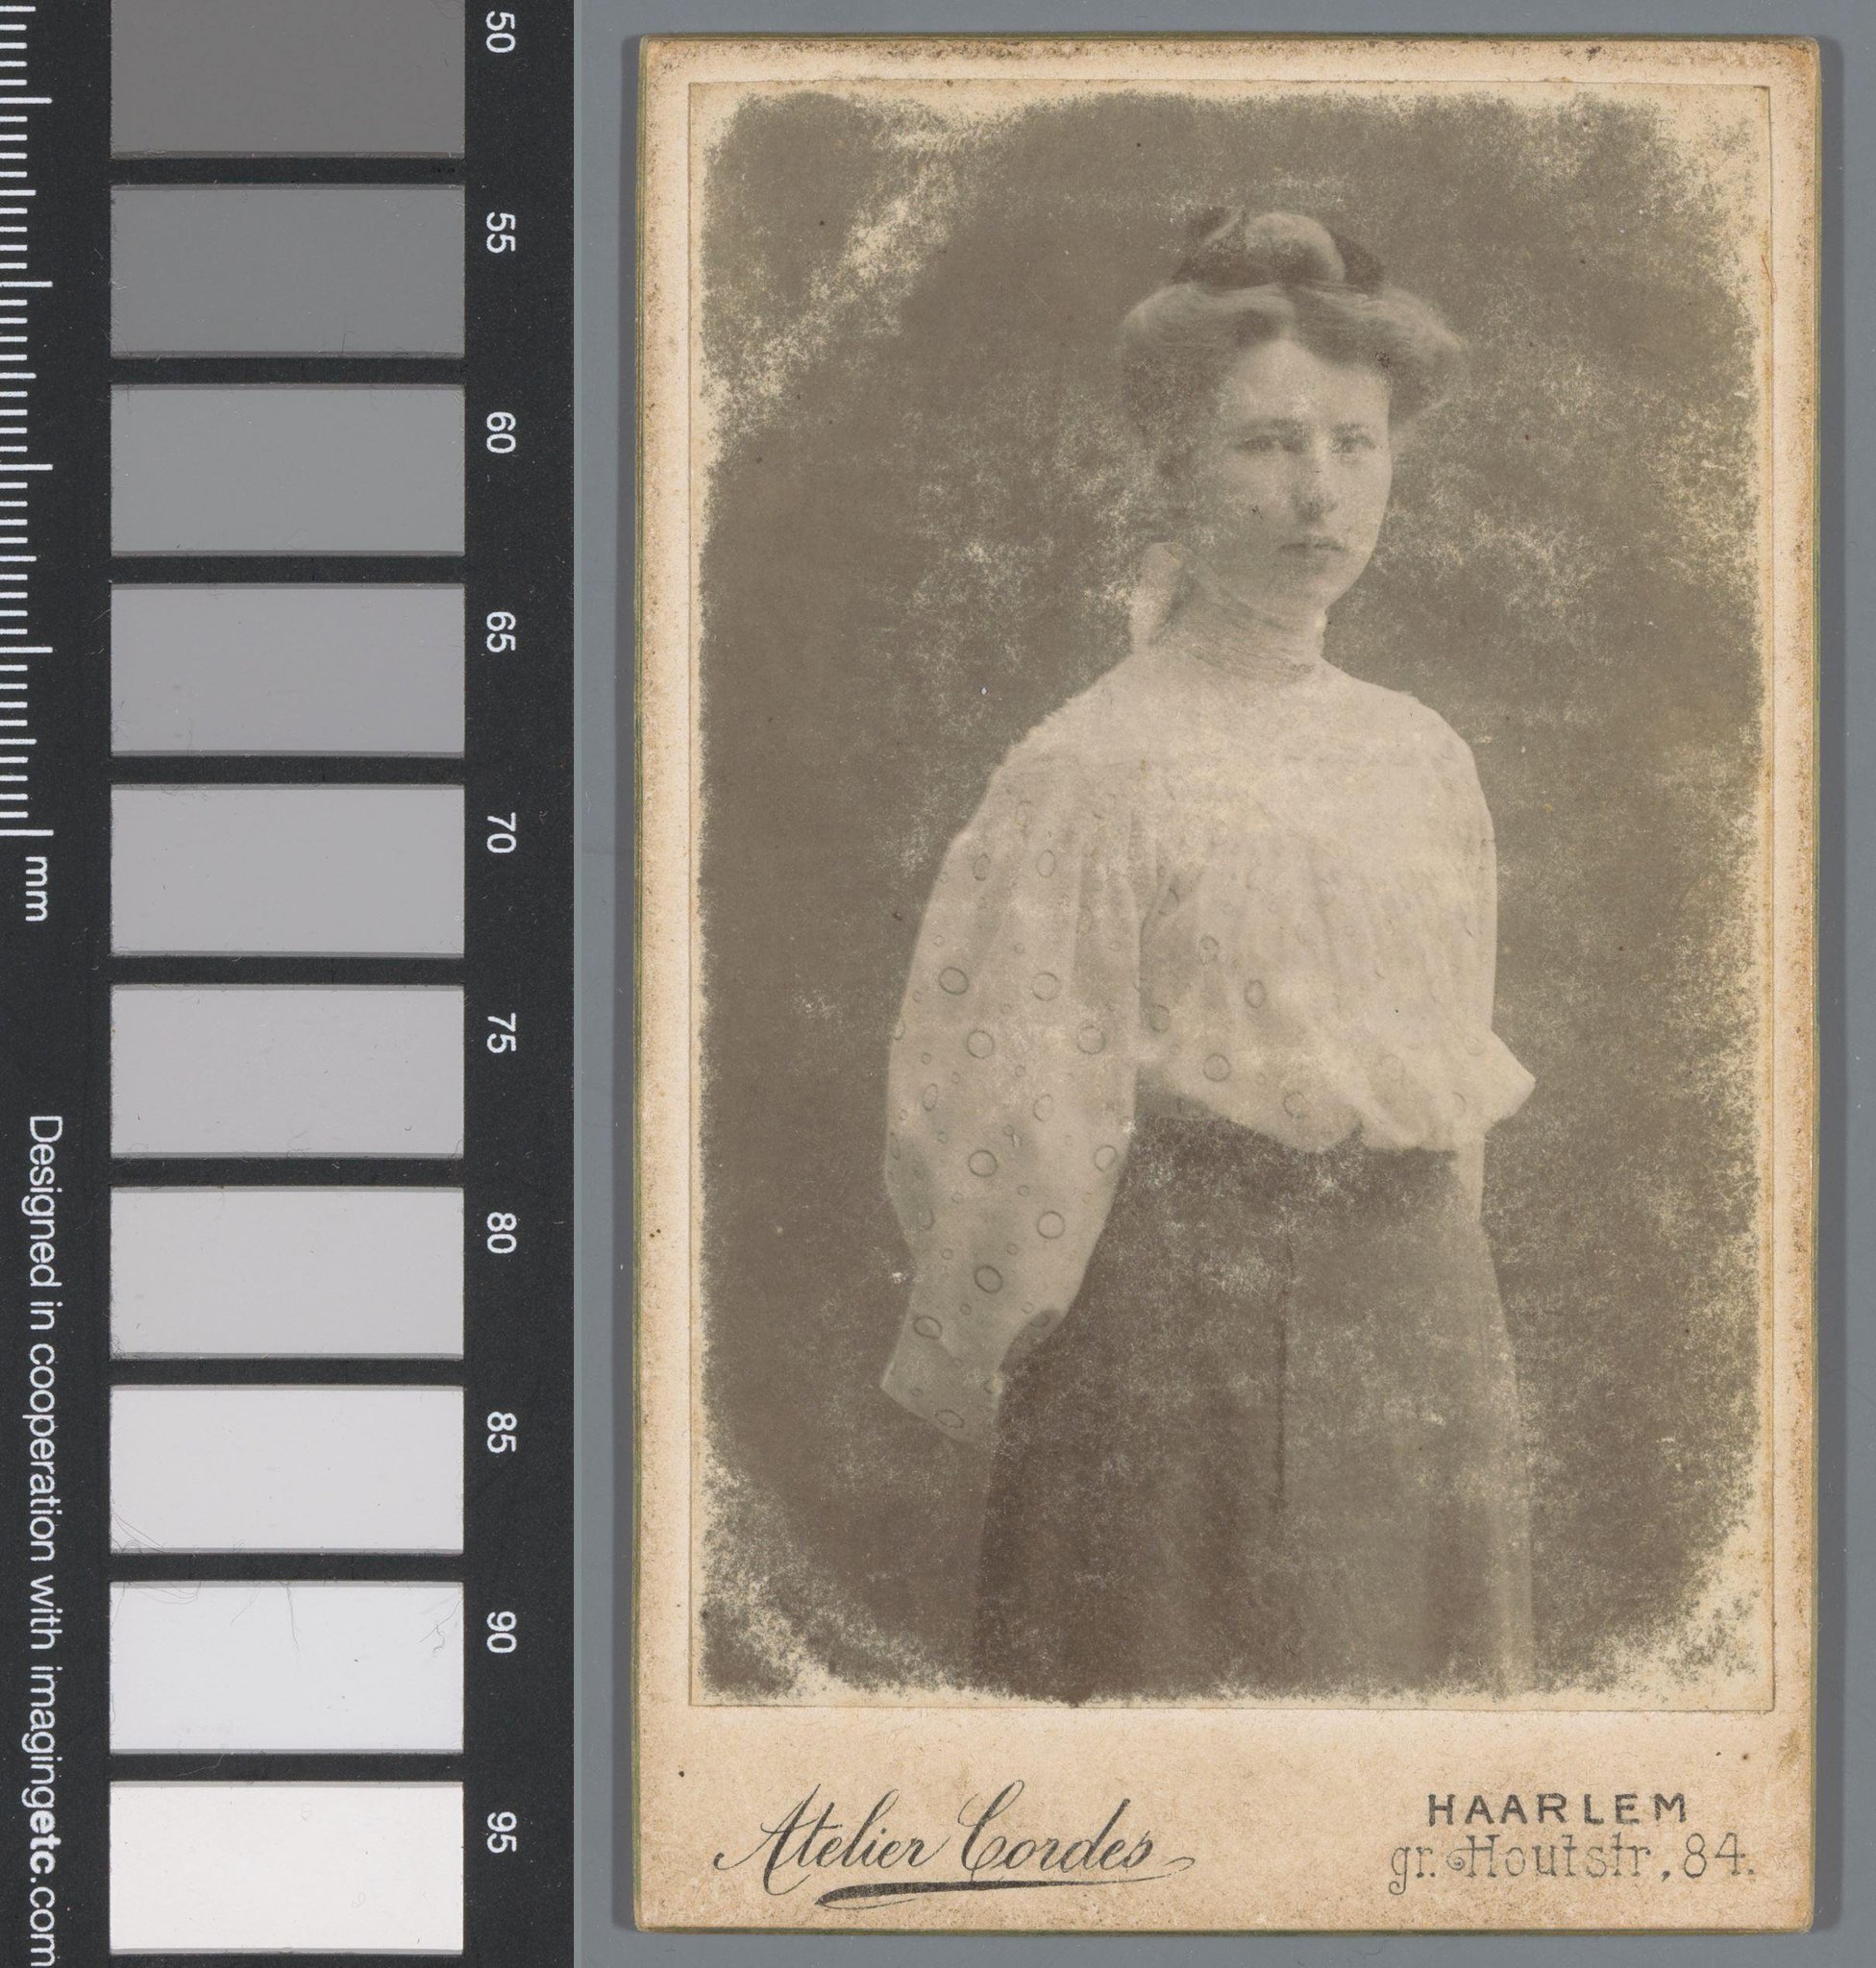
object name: carte de visite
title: Portret van een onbekende jonge vrouw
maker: carel frederik cordes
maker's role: fotograaf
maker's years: 1851-1927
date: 1885-1914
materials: paper, cardboard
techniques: gelatin silver print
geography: haarlem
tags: adolescent, young woman, maiden, anonymous historical person portrayed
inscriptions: address: ‘HAARLEM/ gr. Houtstr, 84.’